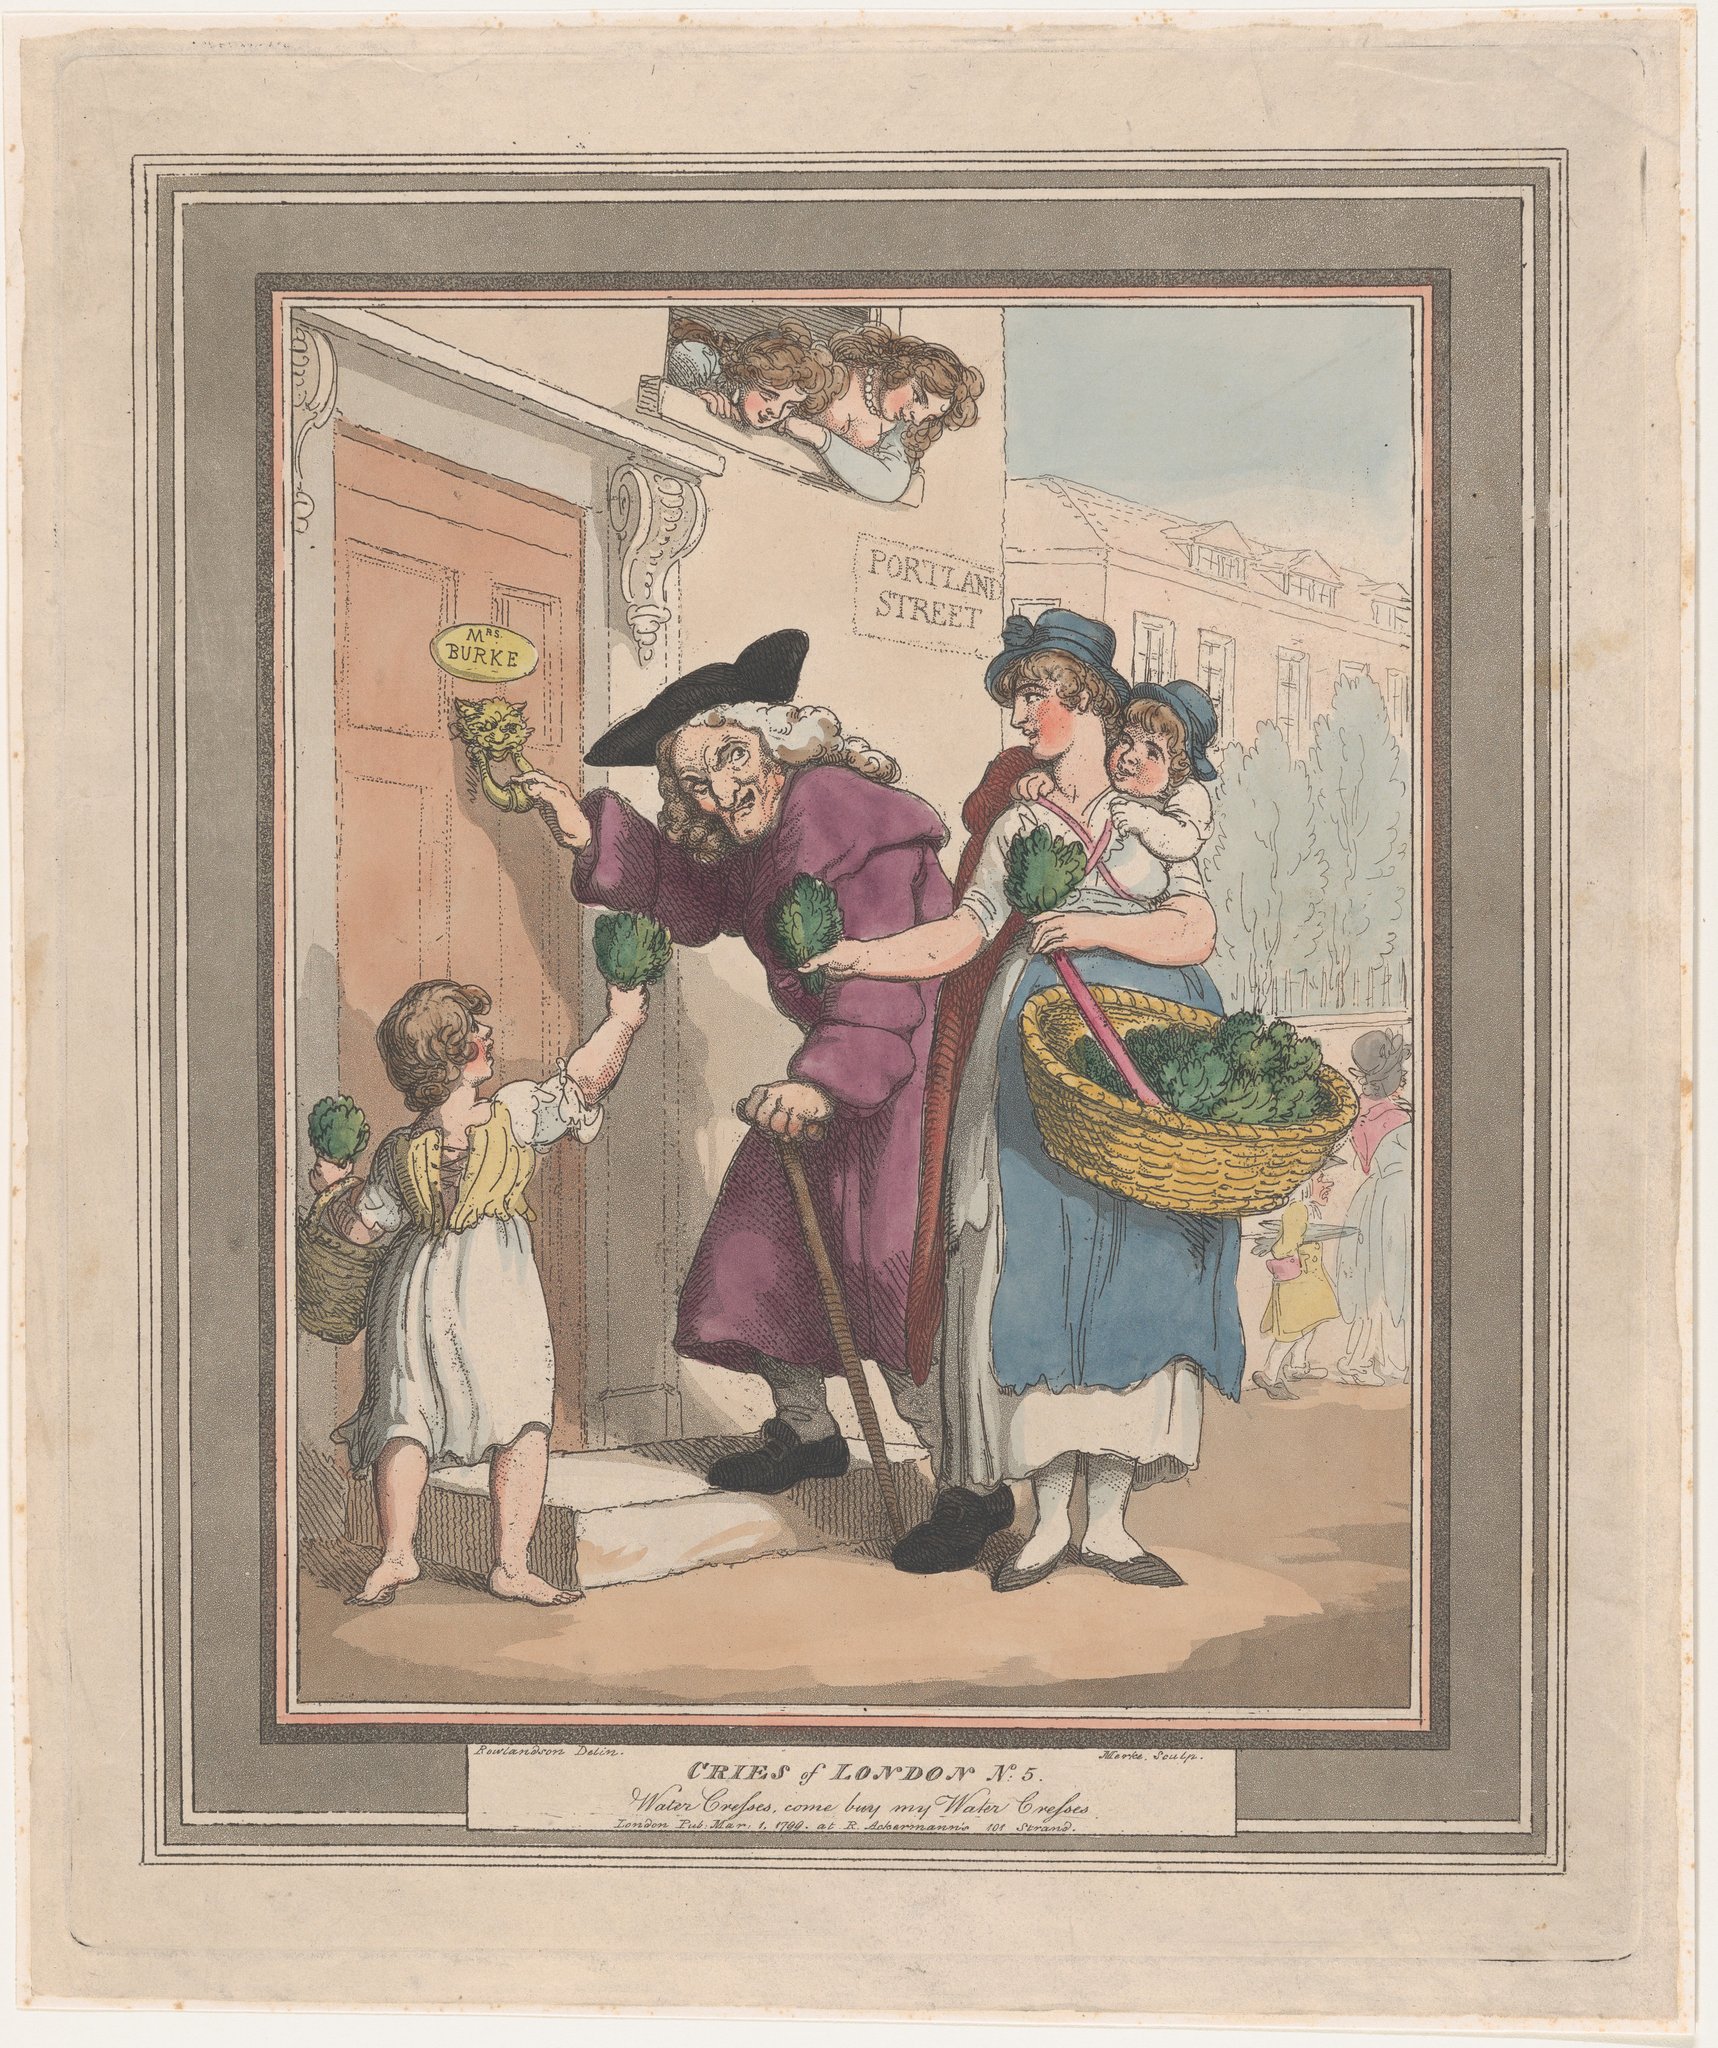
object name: print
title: Cries of London, No. 5: Come Buy My Watercresses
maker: henri merke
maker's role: artist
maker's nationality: swiss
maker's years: 1760-1820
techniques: aquatint, etching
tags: girls,infants,women